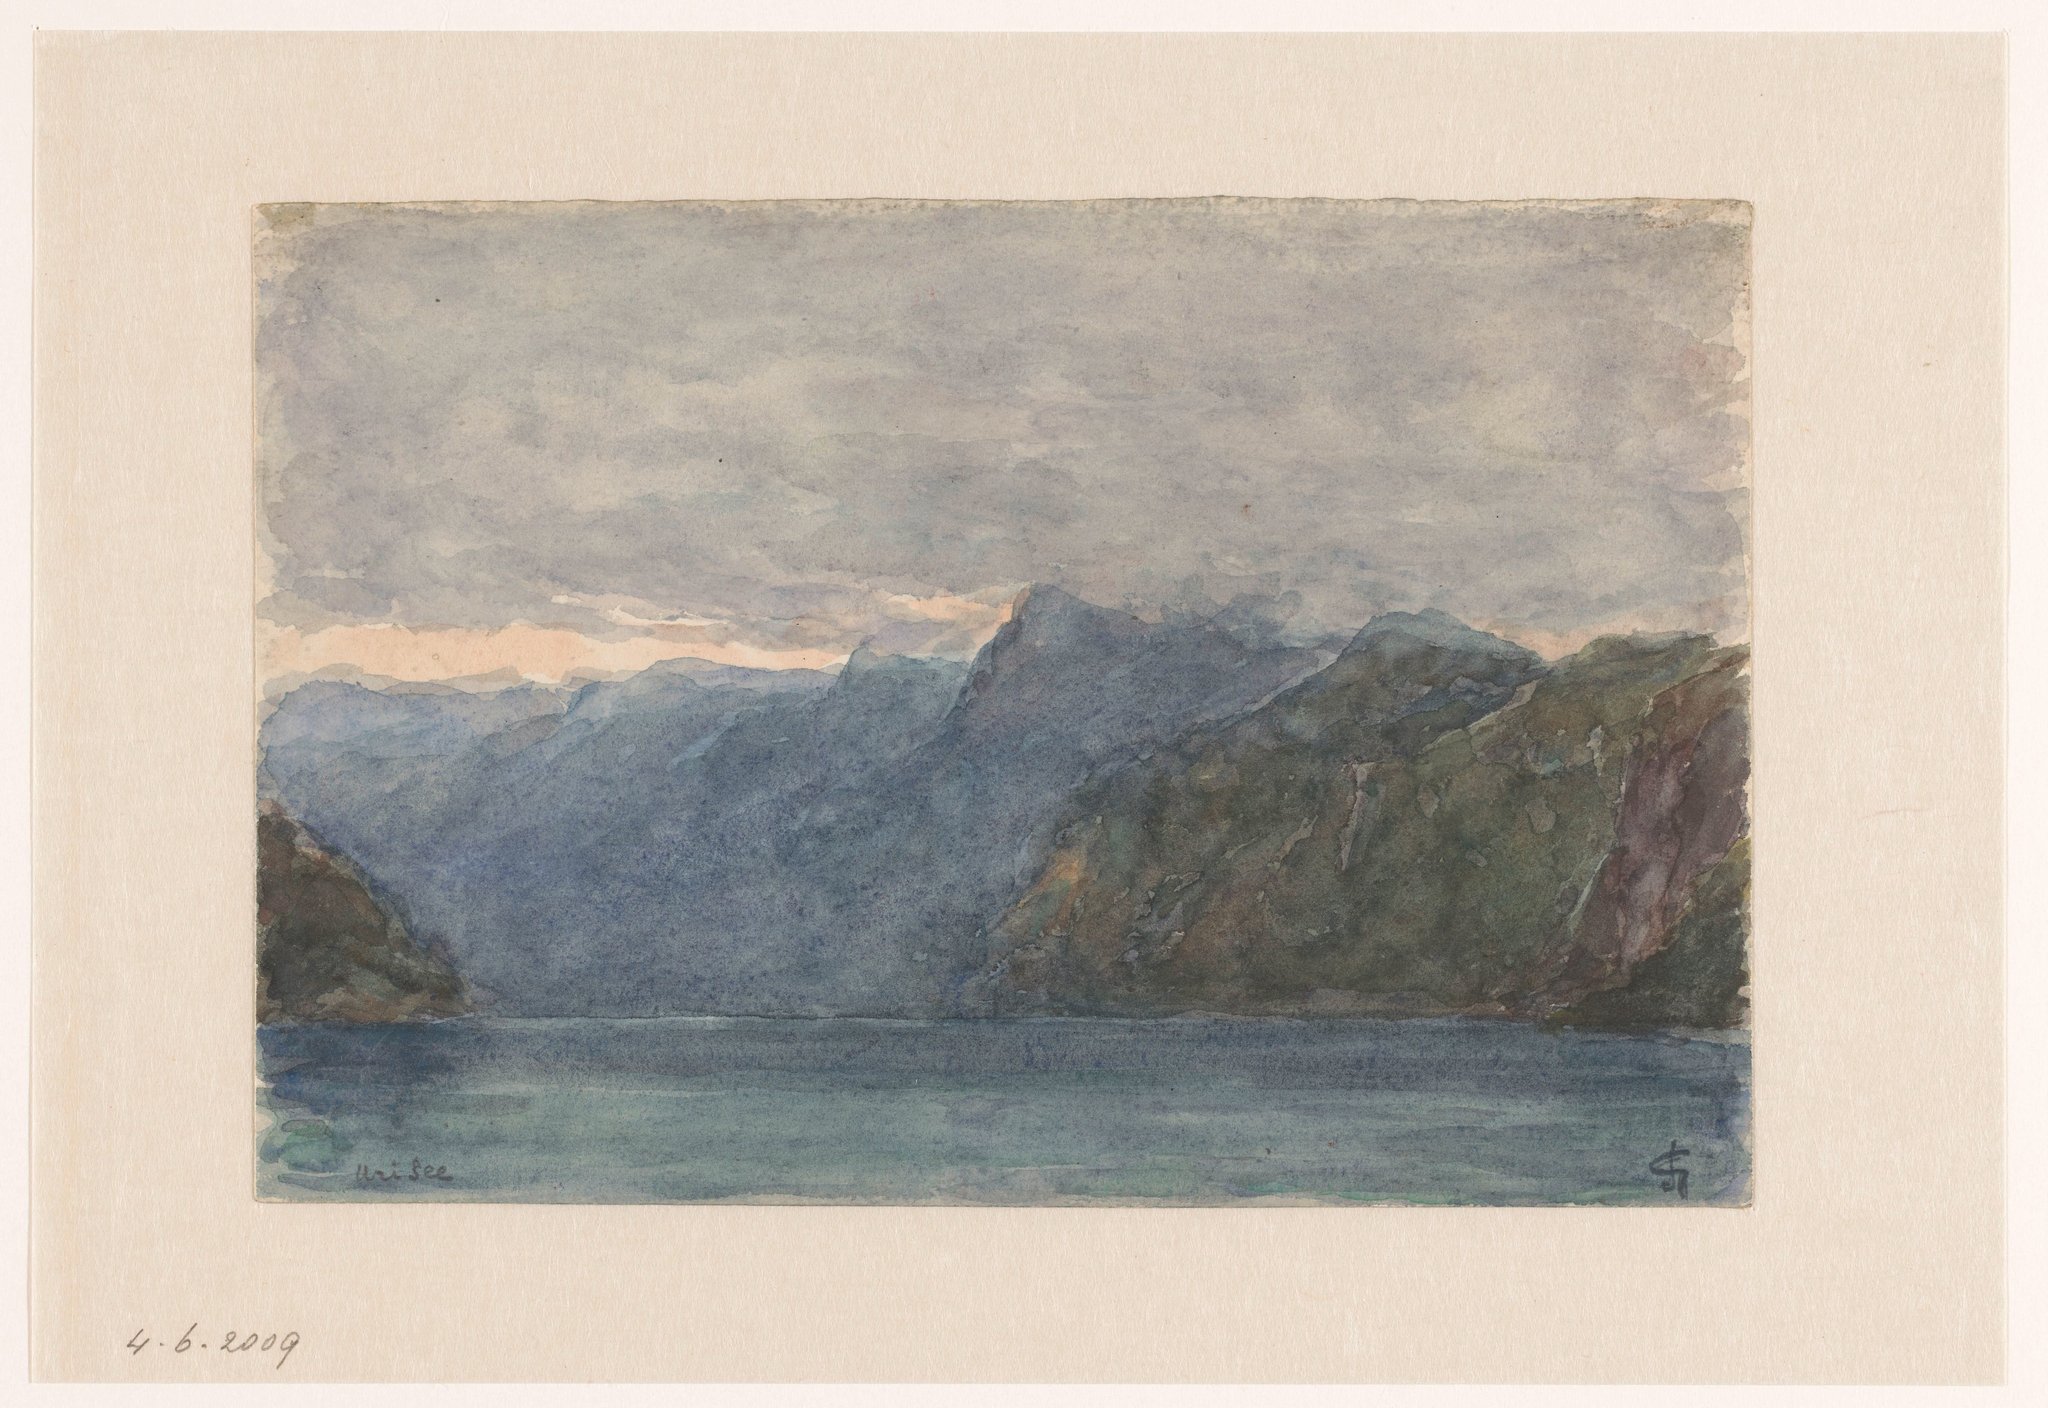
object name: drawing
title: Uri-See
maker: carel nicolaas storm van s-gravesande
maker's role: draughtsman, print maker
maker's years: 1841-1924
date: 1851-1924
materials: paper, watercolor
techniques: brush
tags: sea, switzerland